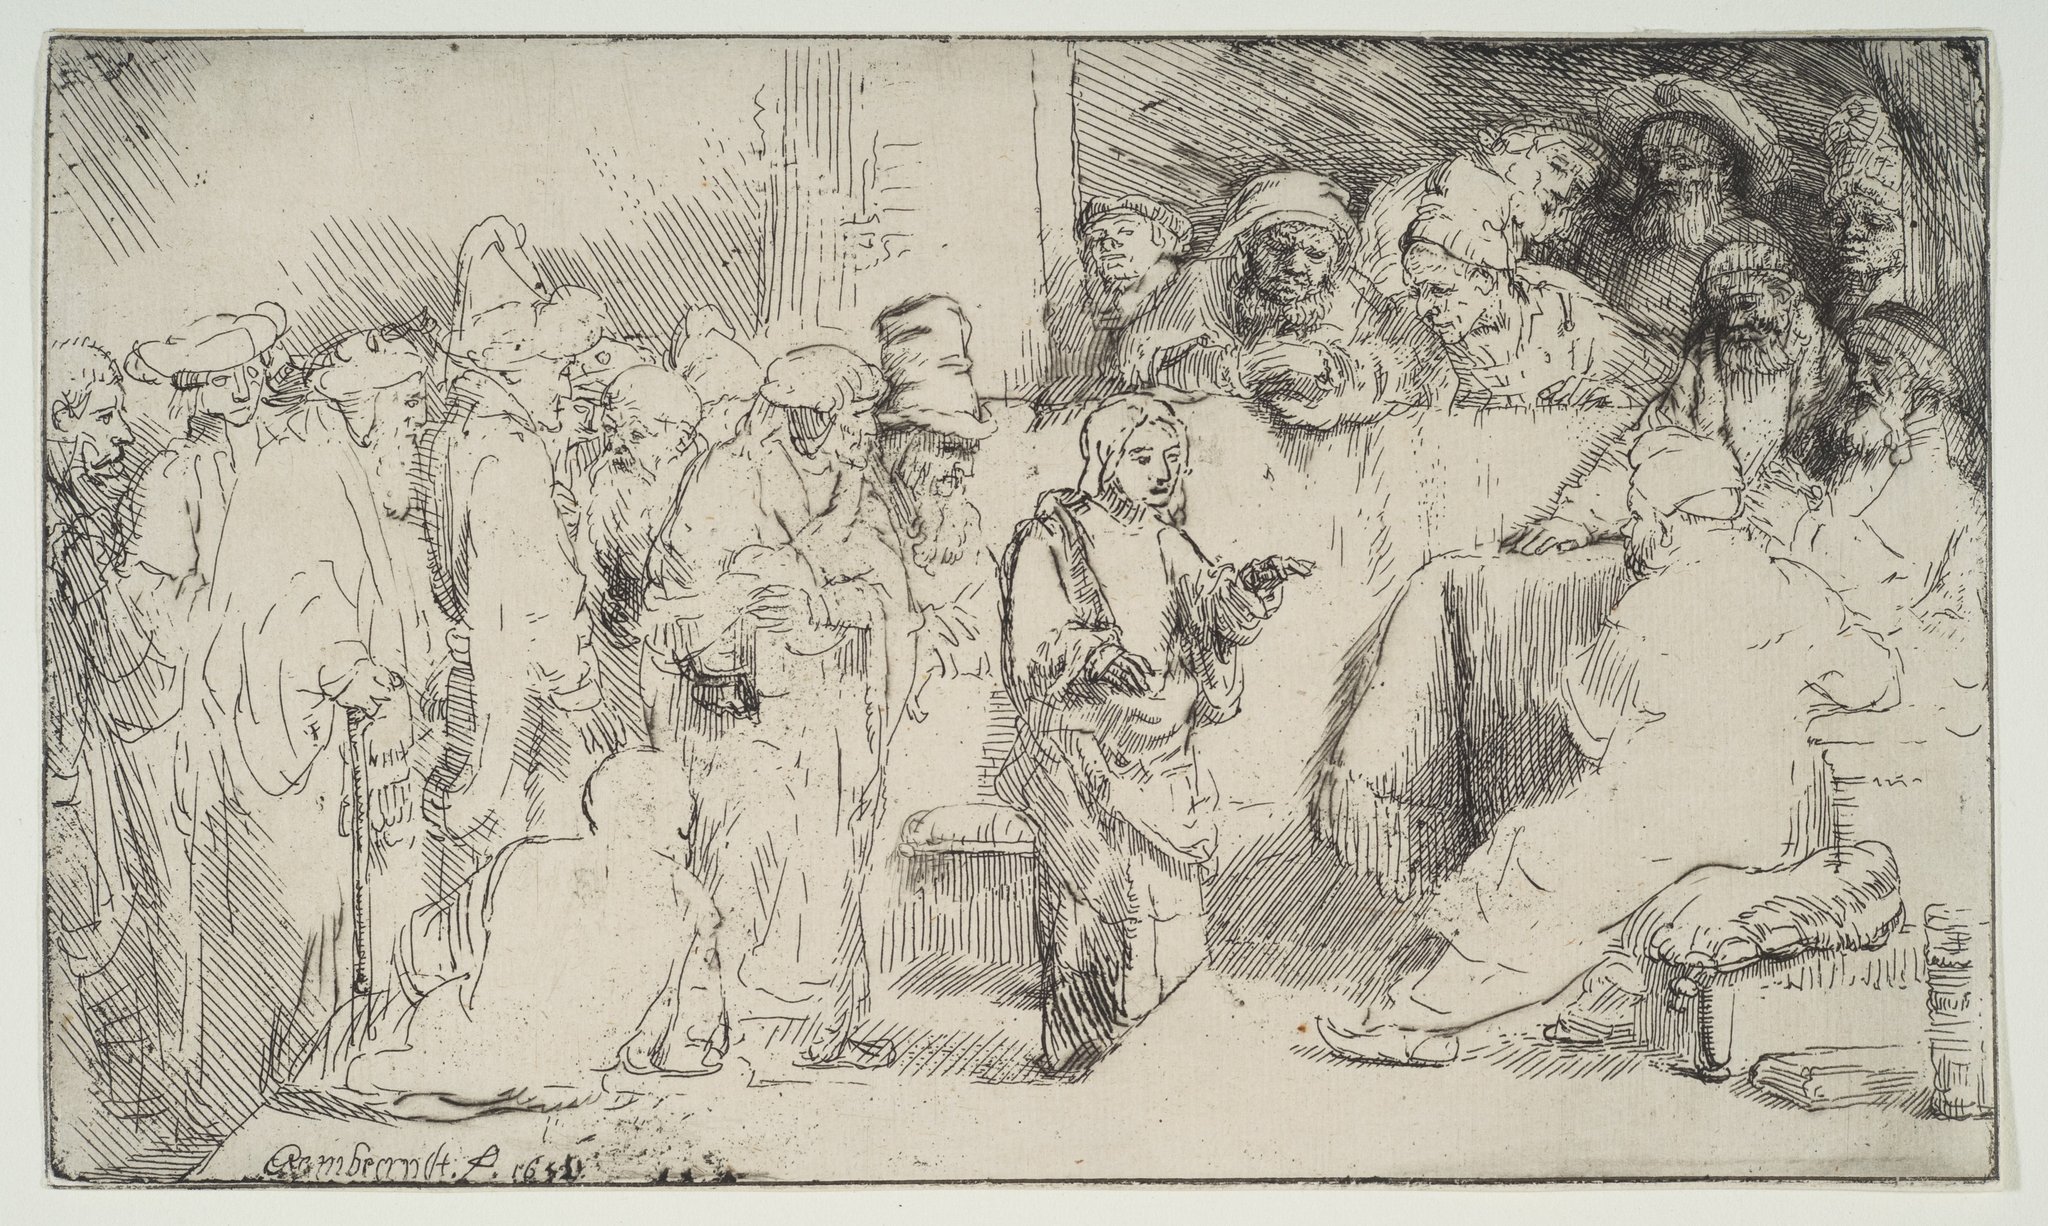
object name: print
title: Christ Disputing with the Doctors; a sketch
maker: rembrandt van rijn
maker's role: artist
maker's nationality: dutch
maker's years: 1606-1669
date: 1652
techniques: etching, pen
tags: christ,crowd,doctors